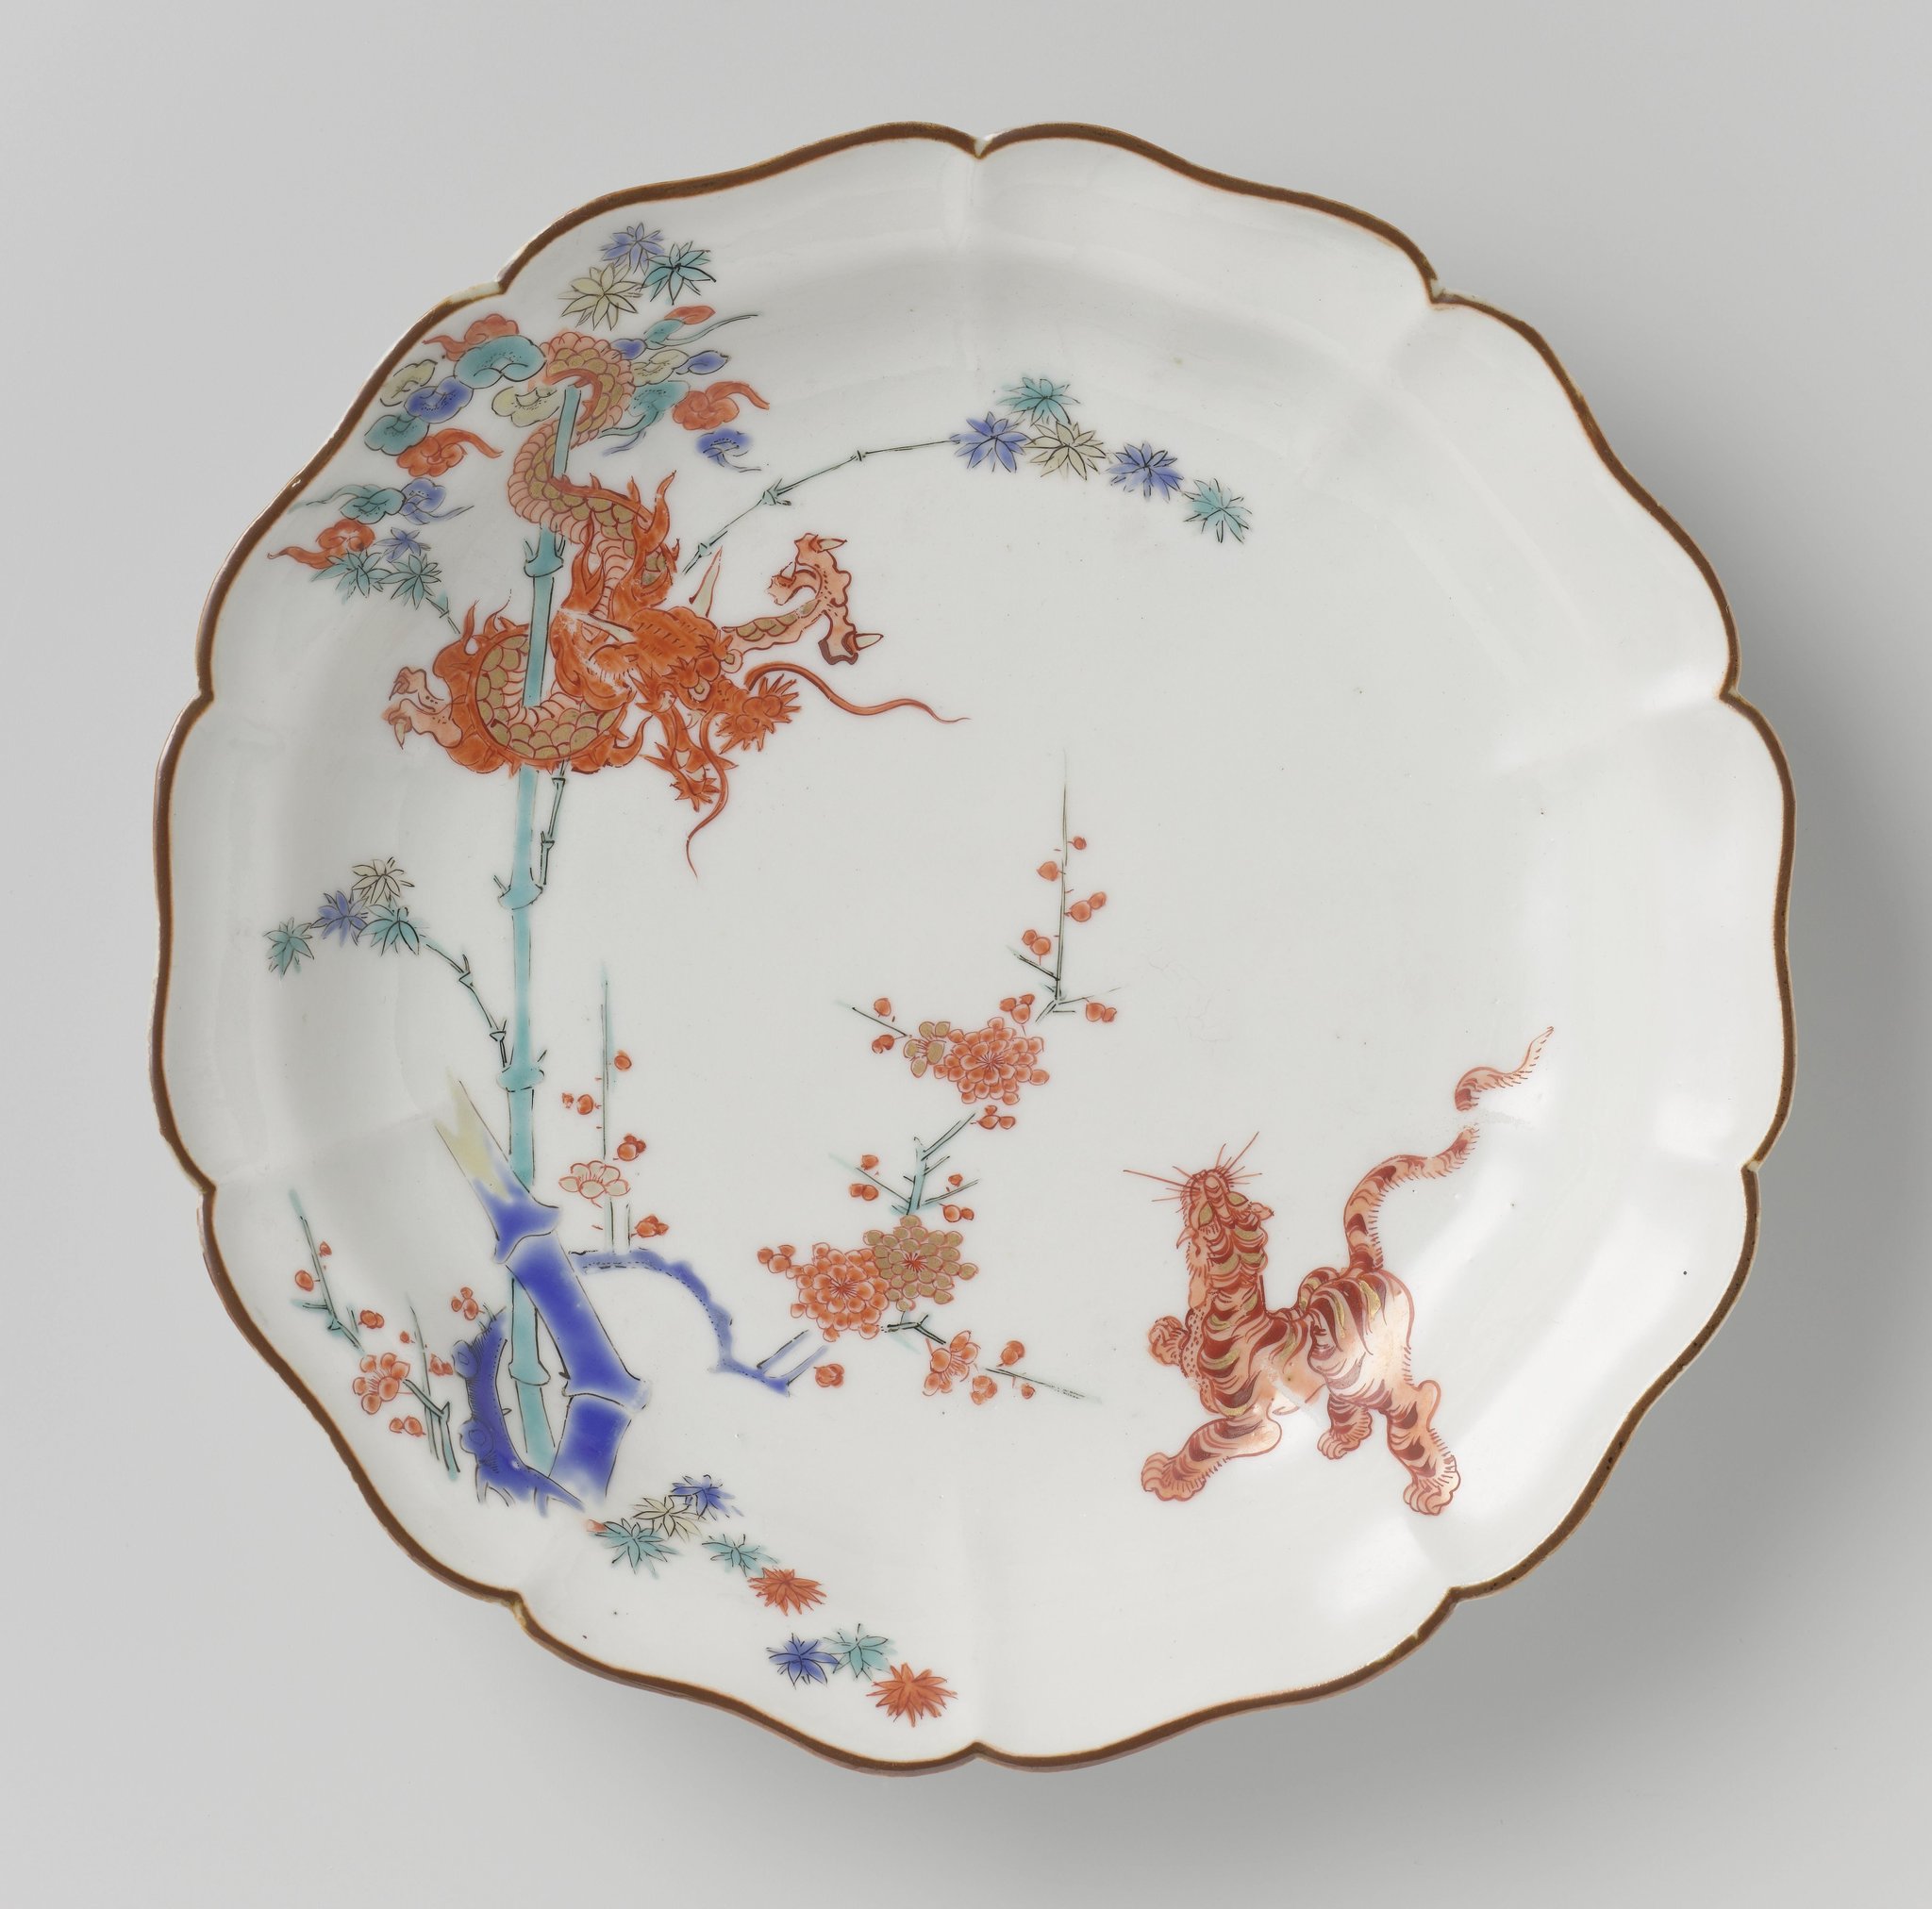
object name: plate dish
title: Lobed dish with dragon, tiger, bamboo and prunus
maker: Anonymous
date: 1670-1690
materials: glaze, paint, porcelain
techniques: firing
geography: arita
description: Small dish, c. 1690 - 1710.